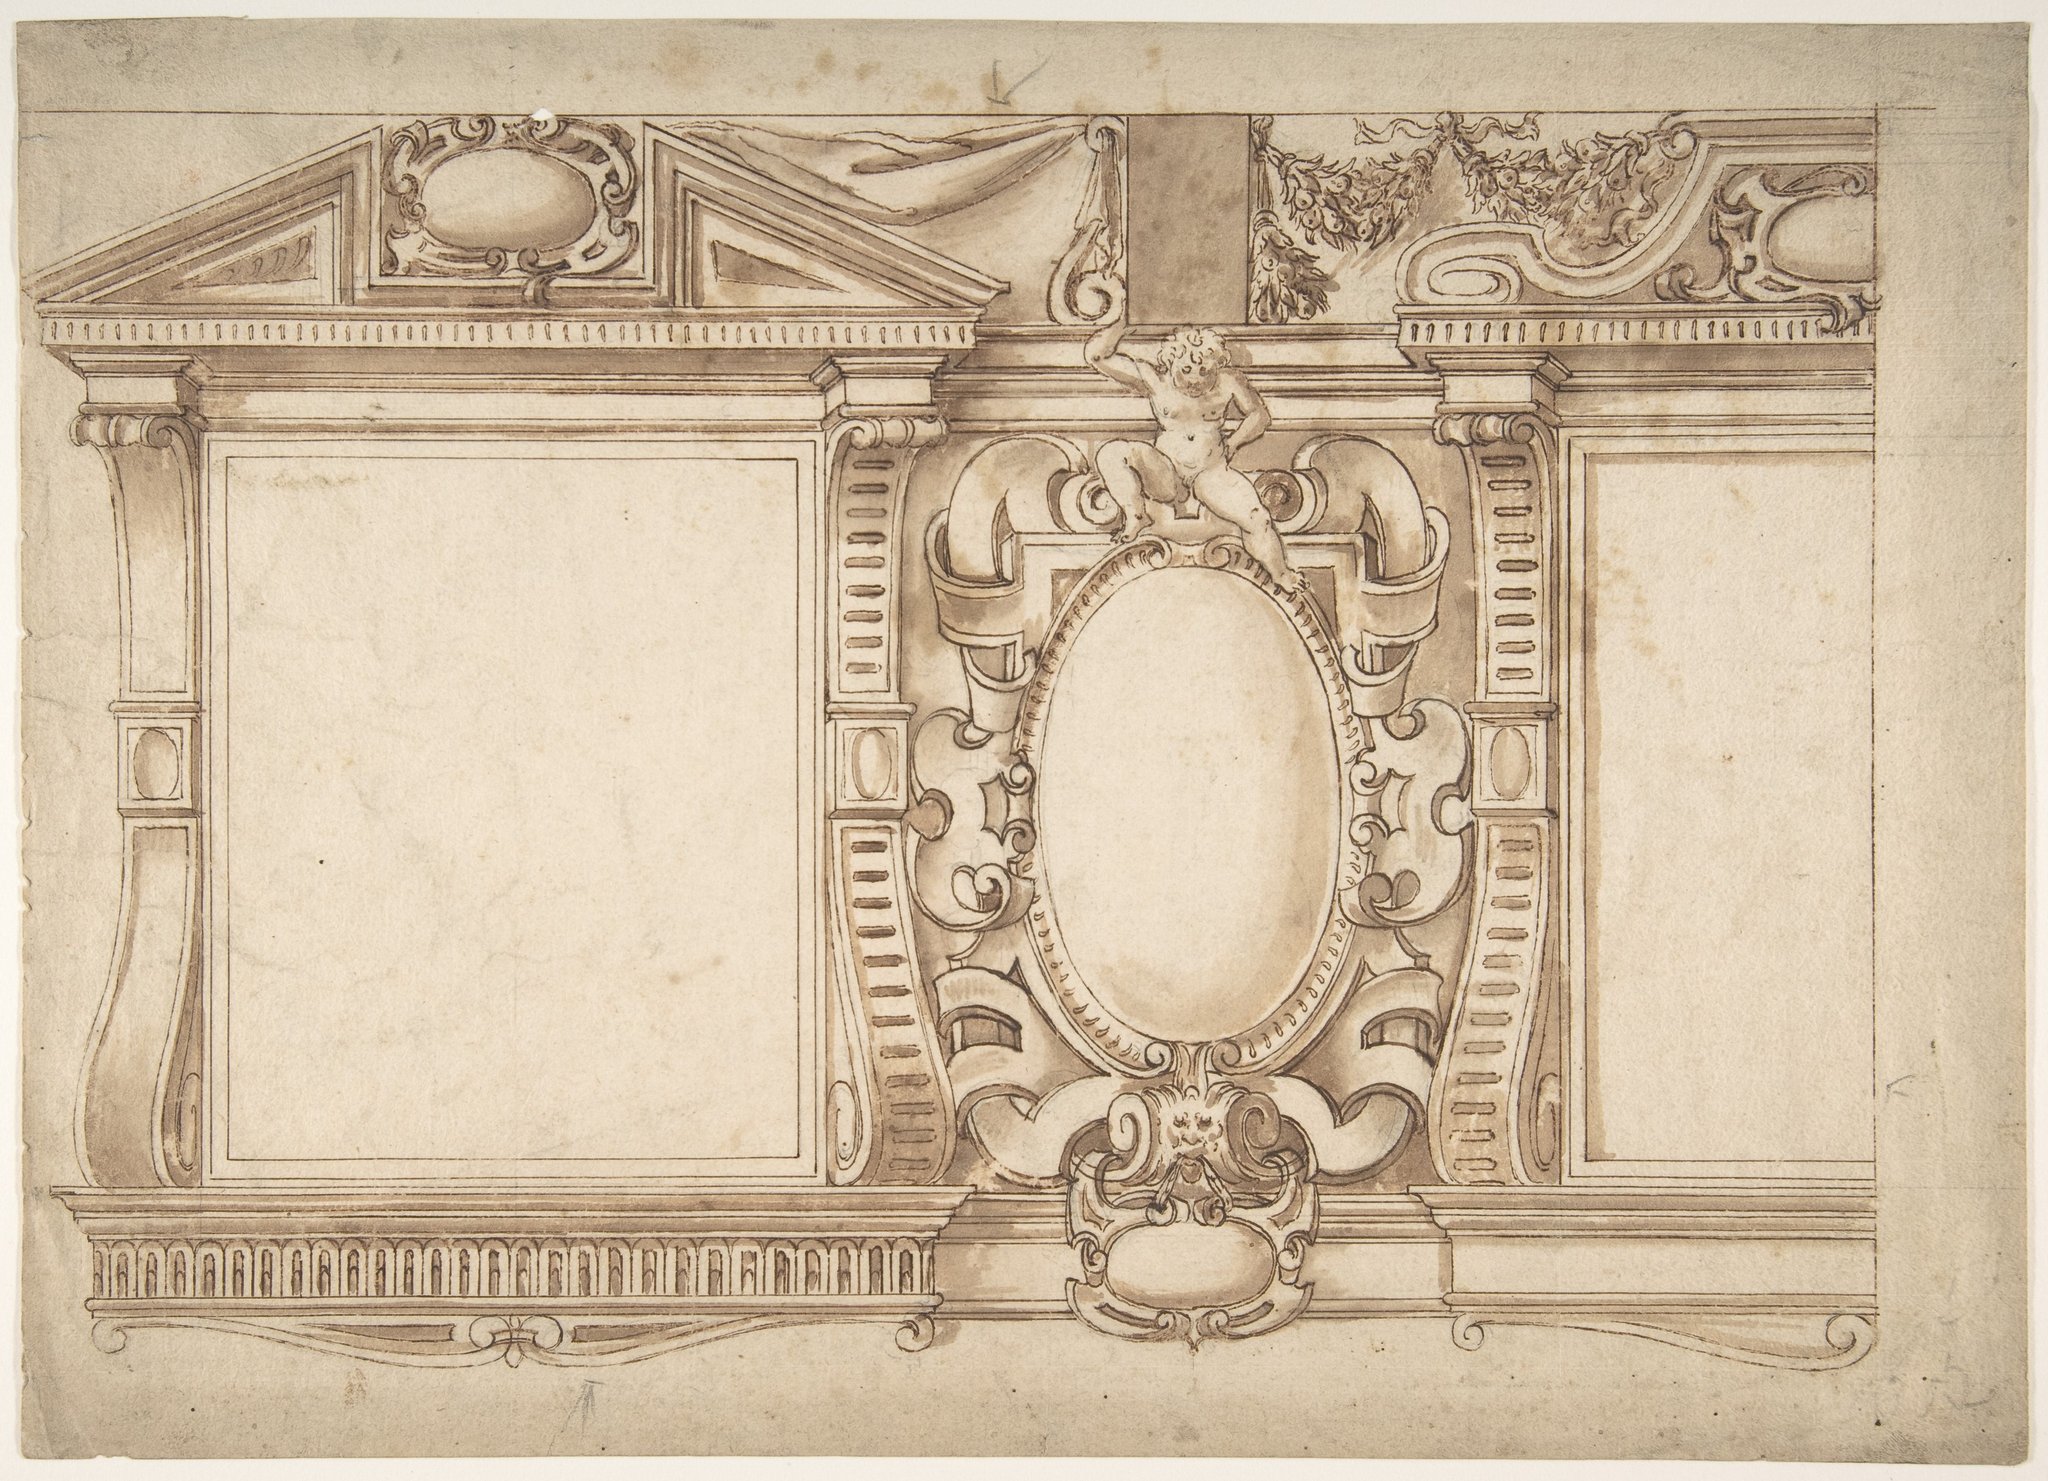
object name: drawing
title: Design for an Interior Wall with Pedimented Niches or Windows, Flanking a Cartouche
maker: anonymous, italian, 16th to 17th century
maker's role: artist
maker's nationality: italian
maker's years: 1500-1700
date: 1500-1700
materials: ink, drawing material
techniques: brush, pen, wash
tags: architecture